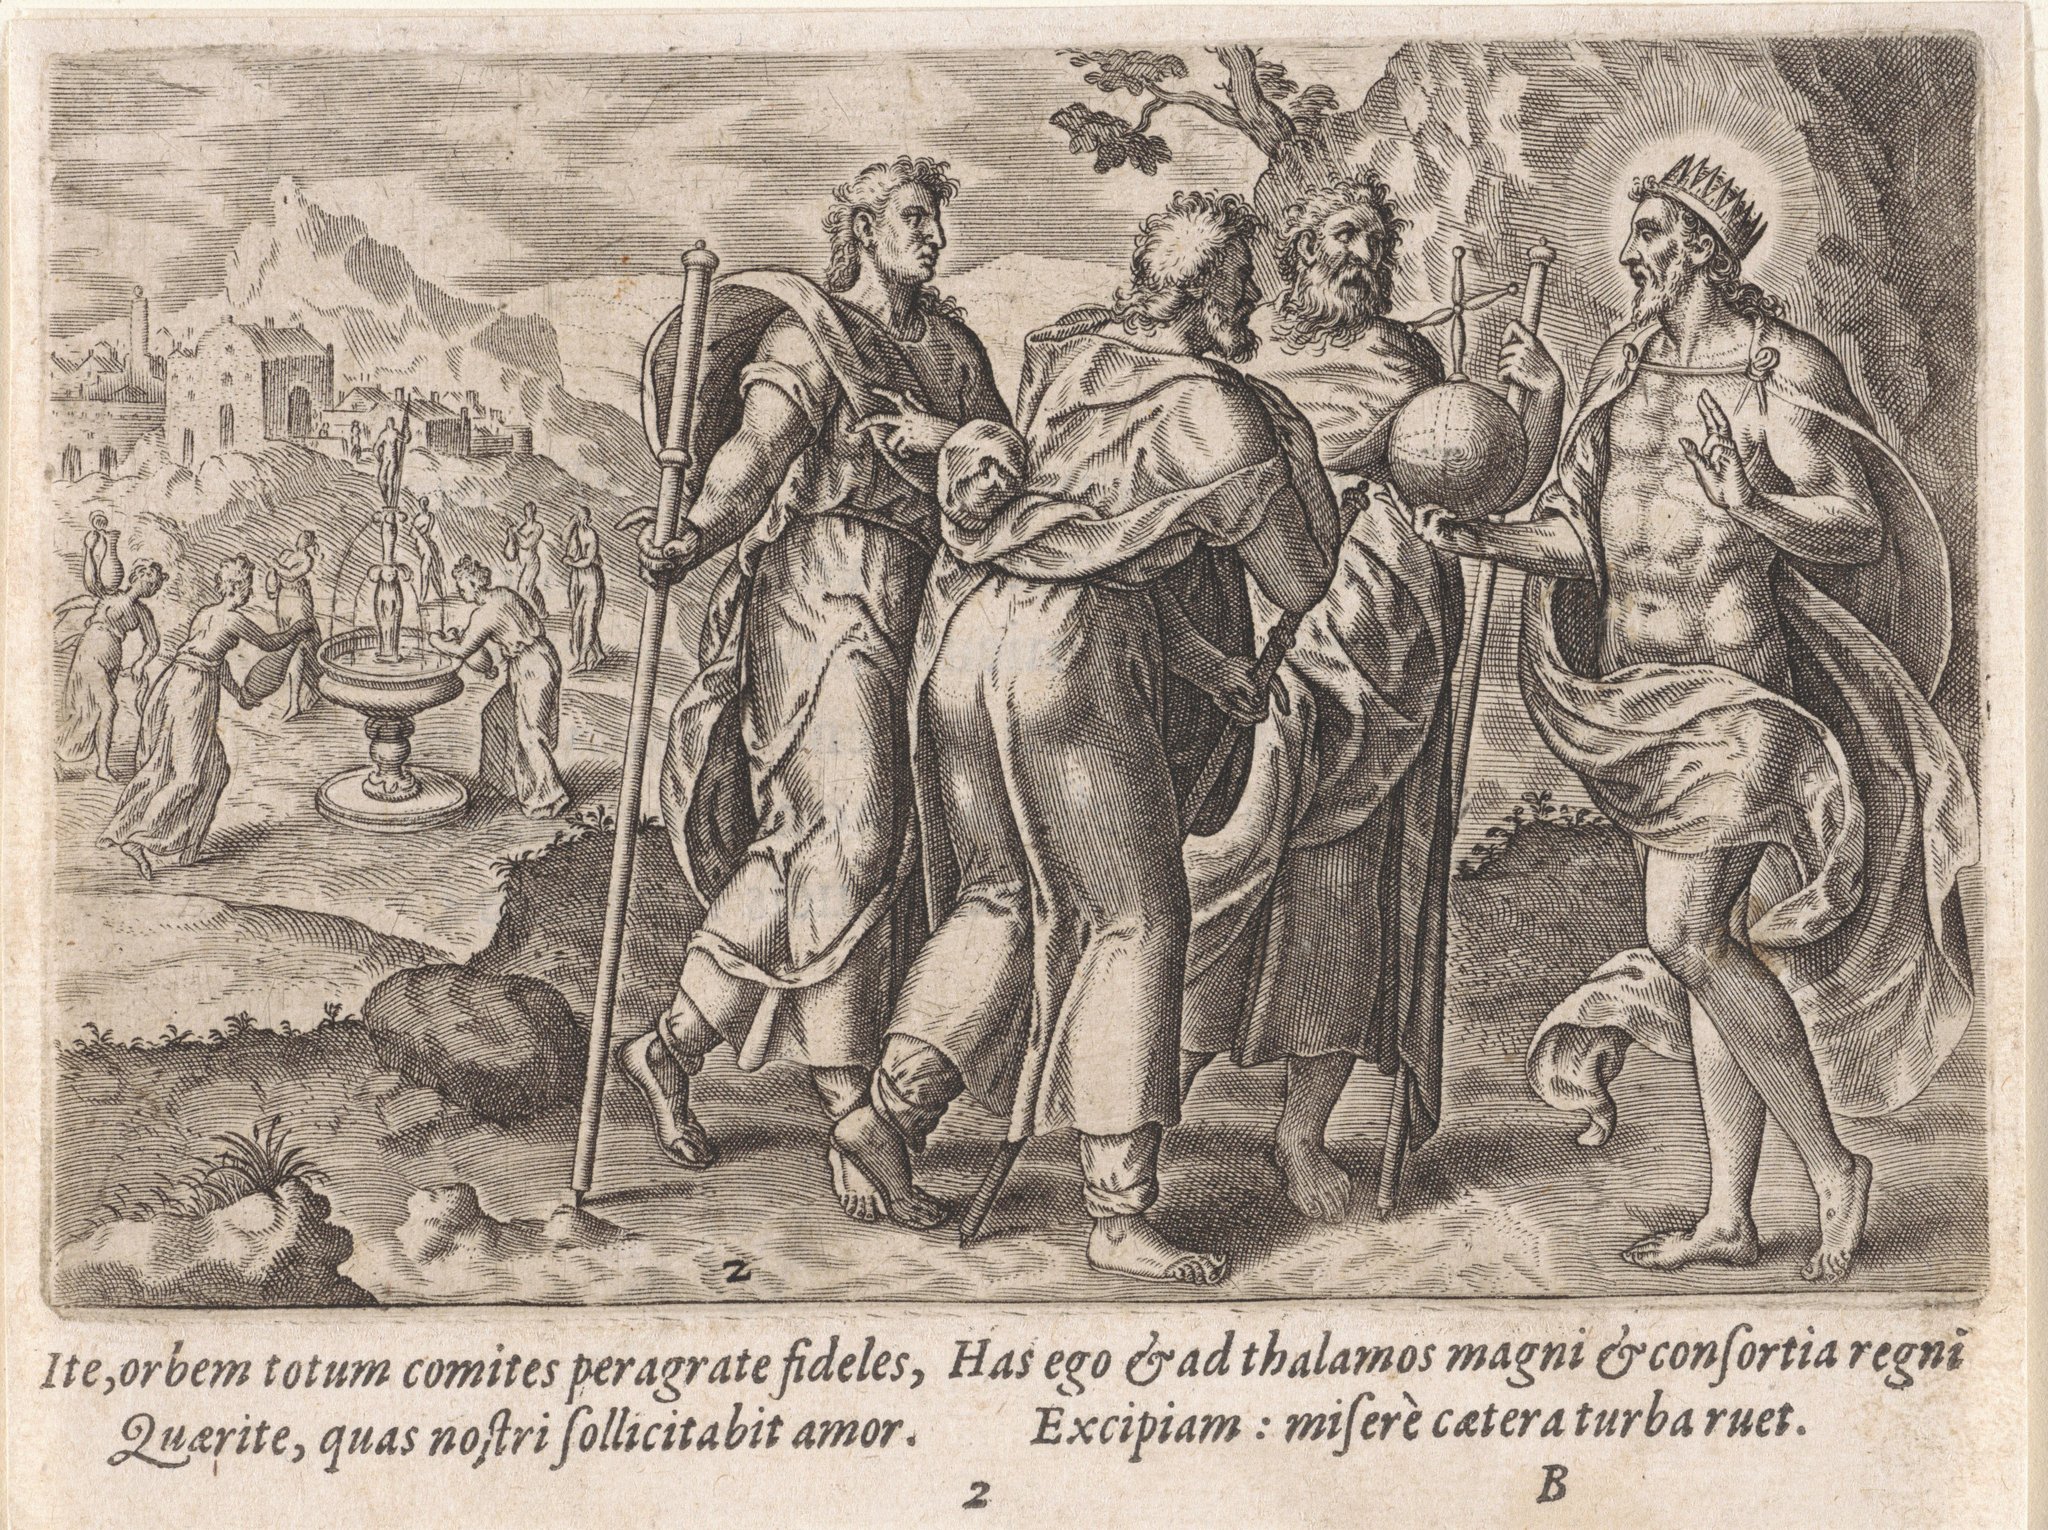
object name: print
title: Koning op zoek naar een echtgenote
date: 1574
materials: paper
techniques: engraving, letterpress printing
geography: antwerp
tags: ruler commanding, official; civil servant; functionary (in general)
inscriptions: collector's mark: Lugt 2228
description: De koning (Christus), met een rijksappel in de hand, stuurt drie bedienden er op uit om op zoek te gaan naar trouwe vrouwen. Op de achtergrond allerlei vrouwen rond een fontein. In de marge een vierregelig onderschrift, in twee kolommen, in het Latijn.